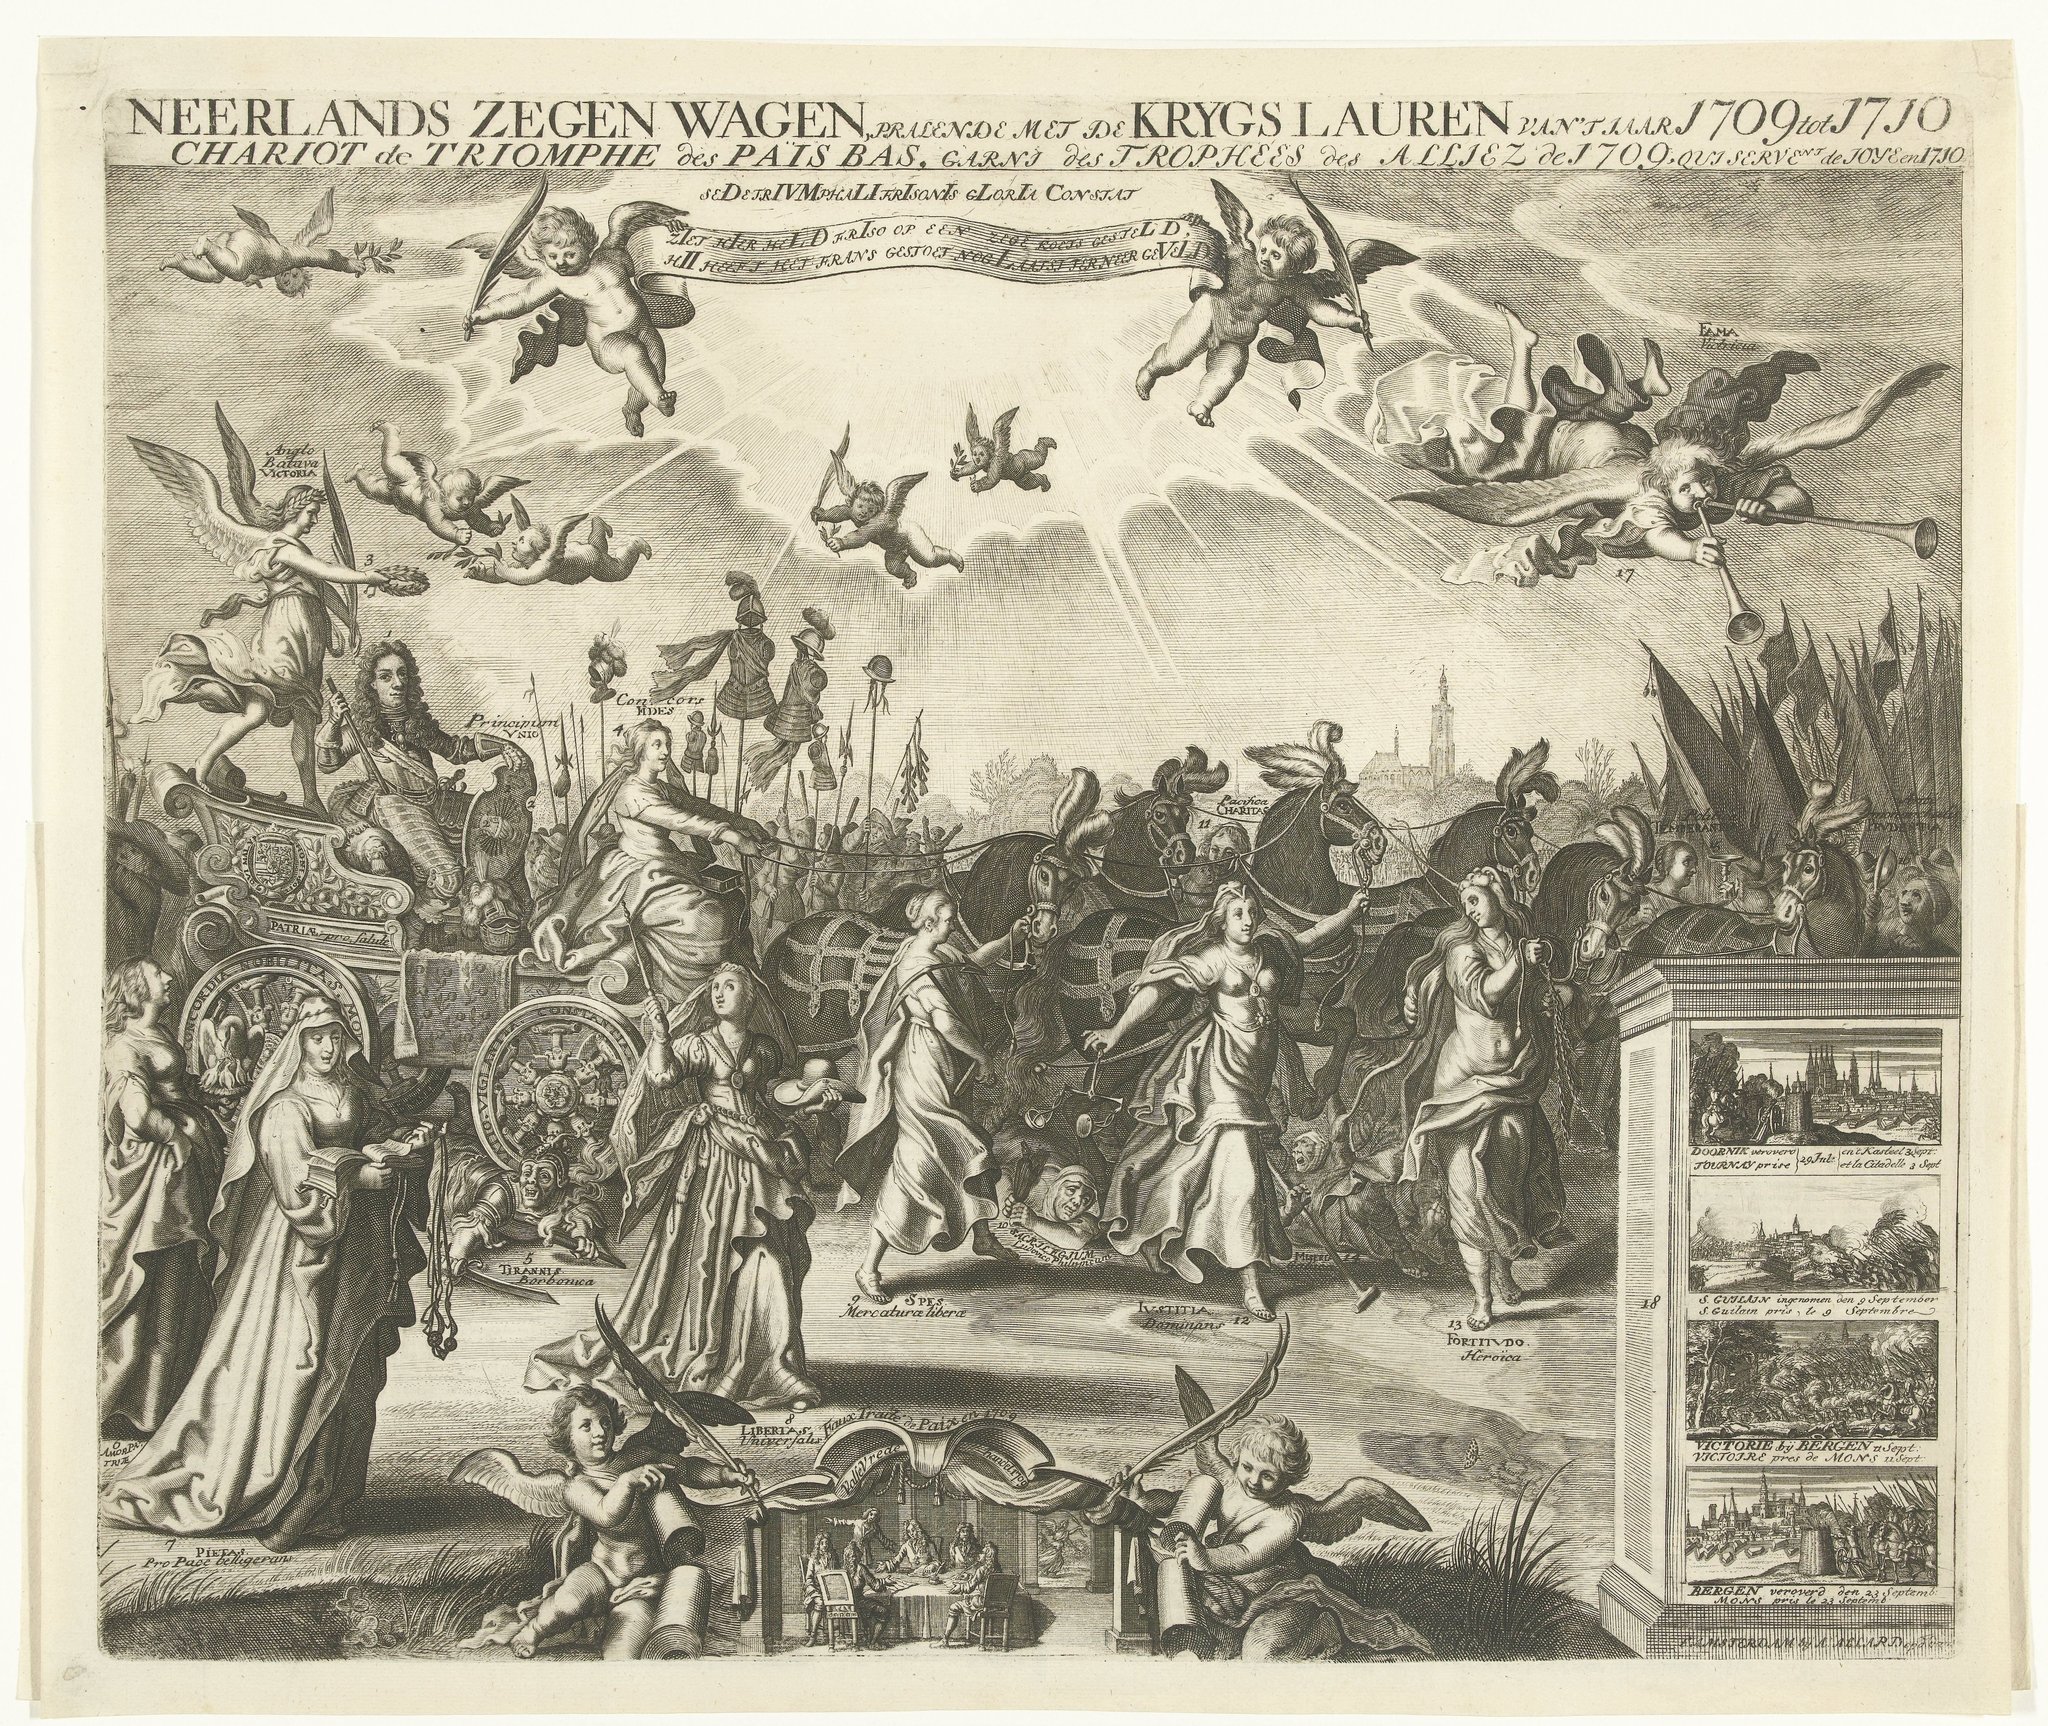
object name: print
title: Neerlands Zegen Wagen, pralende met de Krygslauren van 't jaar 1709 tot 1710 / Chariot de Triomphe des Pais Bas (...)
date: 1630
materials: paper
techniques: engraving, etching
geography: northern netherlands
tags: johan willem friso (prins van oranje-nassau), 'sapientia' and the seven virtues, i.e. the three theological and the four cardinal virtues, symbolic triumphs of individual persons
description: Allegorie ter ere van de overwinningen door de Republiek in het jaar 1709. Triomfoptocht met Johan Willem Friso, prins van Oranje-Nassau in een strijdwagen gemend door Geloof (Fides), de paarden begeleid door de deugden Hoop (Spes), Rechtvaardigheid (Justitia), Kracht (Fortitudo), Liefde (Charitas), Matigheid (Temperantia) en Voorzichtigheid (Prudentia). Links voor de wagen Liefde voor het Vaderland (Amor Patriae), Vroomheid (Pietas) en Vrijheid (Libertas). In de lucht de Faam (Fama) en engelen. Op de voorgrond twee engelen met een cartouche met een voorstelling van de vredehandel in het jaar 1709. Rechts een zuil met vier kleine voorstellingen van de militaire overwinningen behaald in de zomer van 1709. Bij de prent behoort een tekstblad.